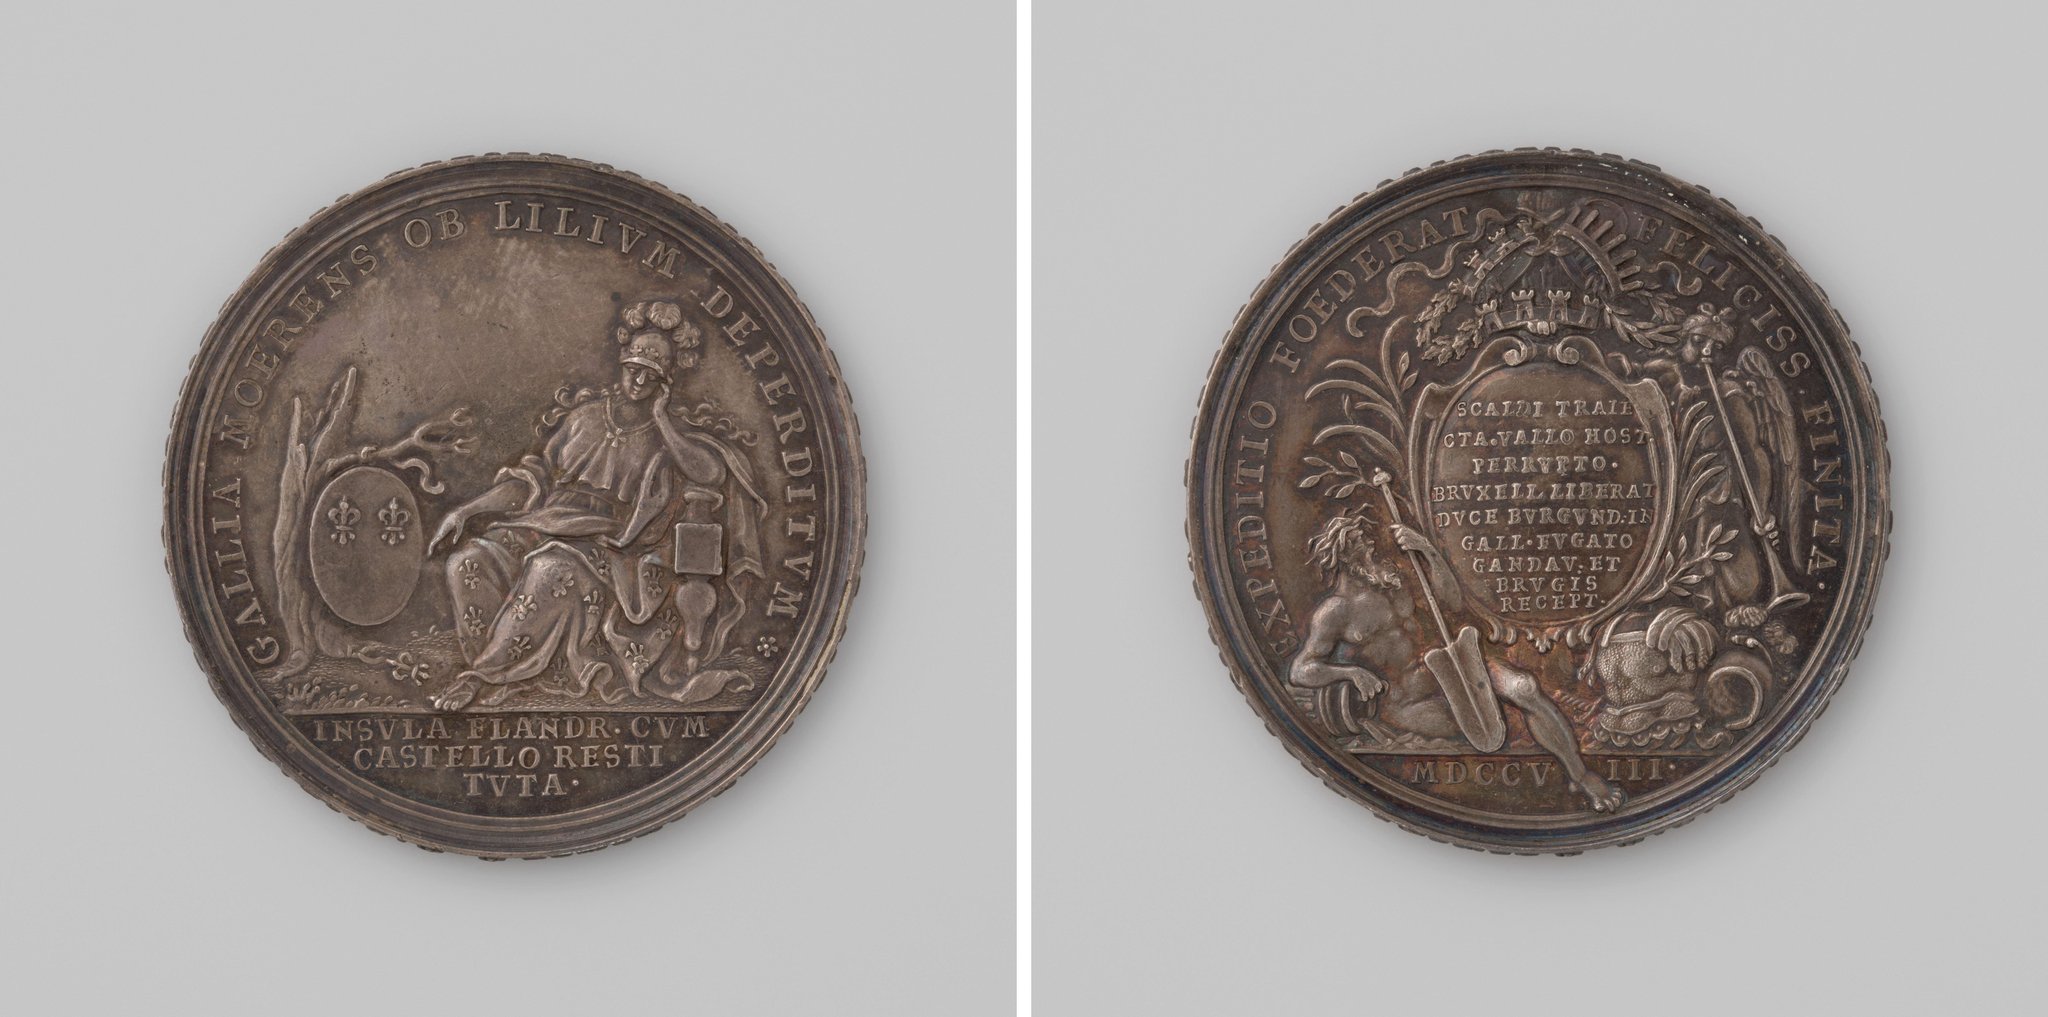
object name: history medal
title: Overwinningen van de bondgenoten in dit jaar behaald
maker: martin brunner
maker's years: 1659-1725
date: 1708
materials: silver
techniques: striking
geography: nuremberg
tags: ghent, brussels, brabant, lille, bruges